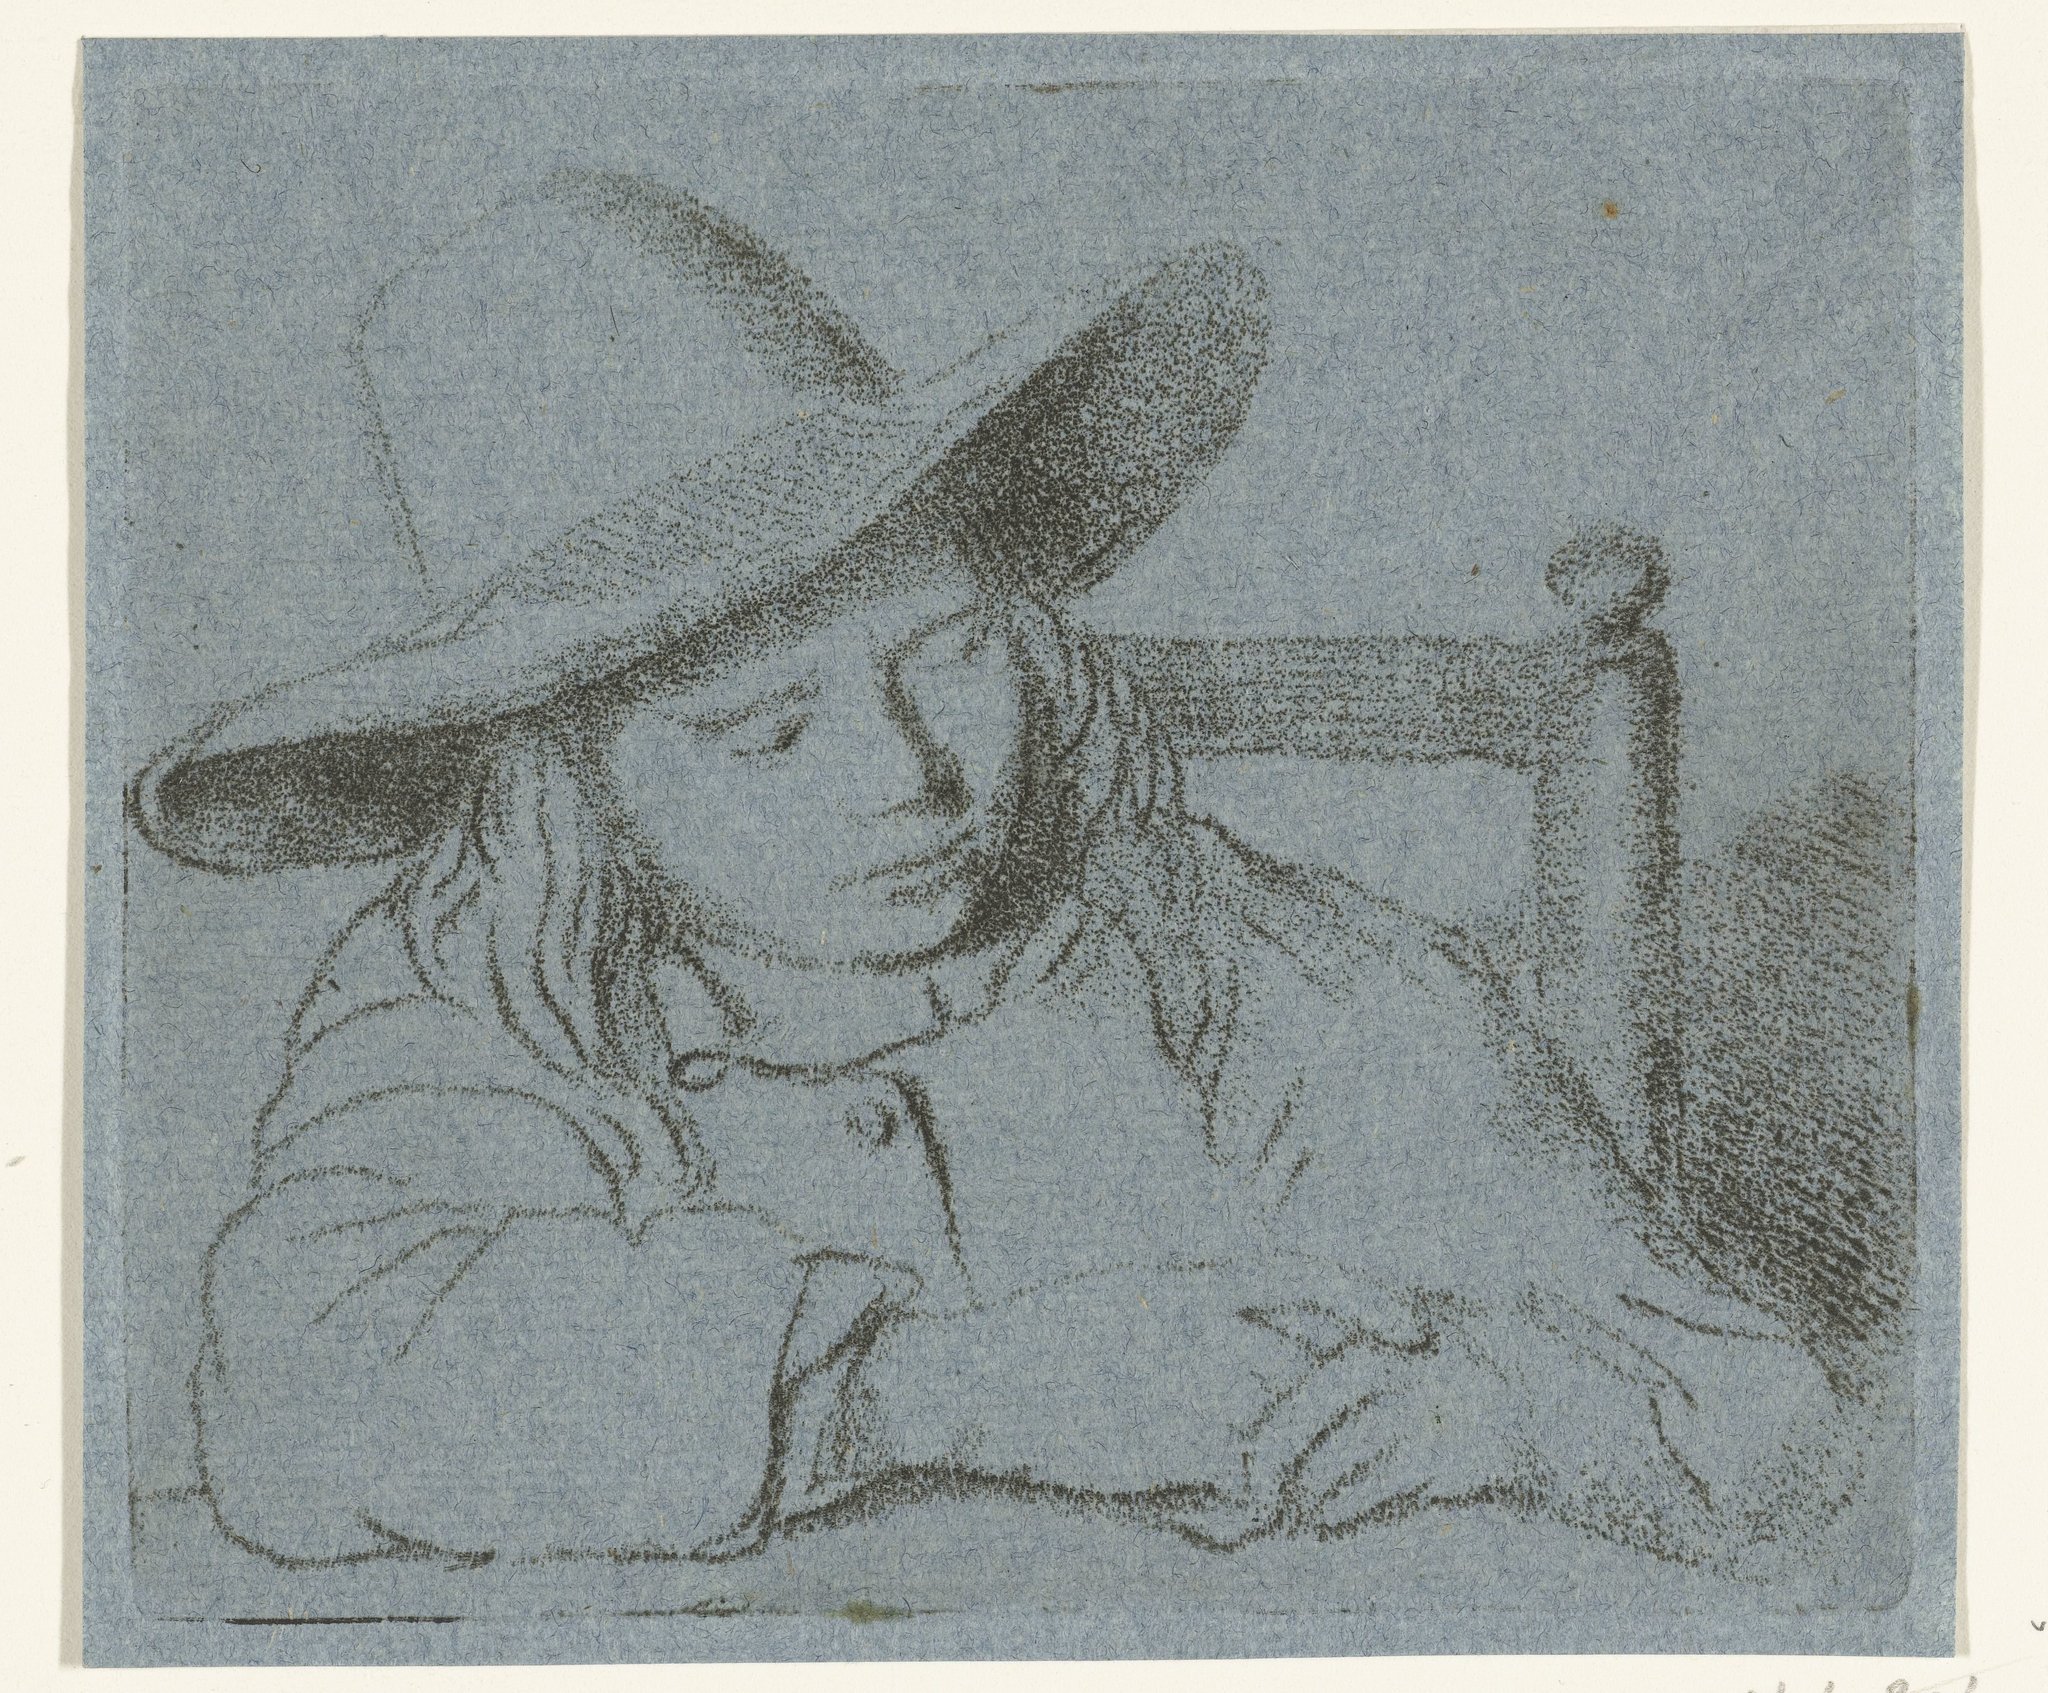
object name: print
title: Slapende jongen met hoed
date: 1798-1837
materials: paper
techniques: etching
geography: netherlands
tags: child, sleeping; unconsciousness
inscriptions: collector's mark: Lugt 2228